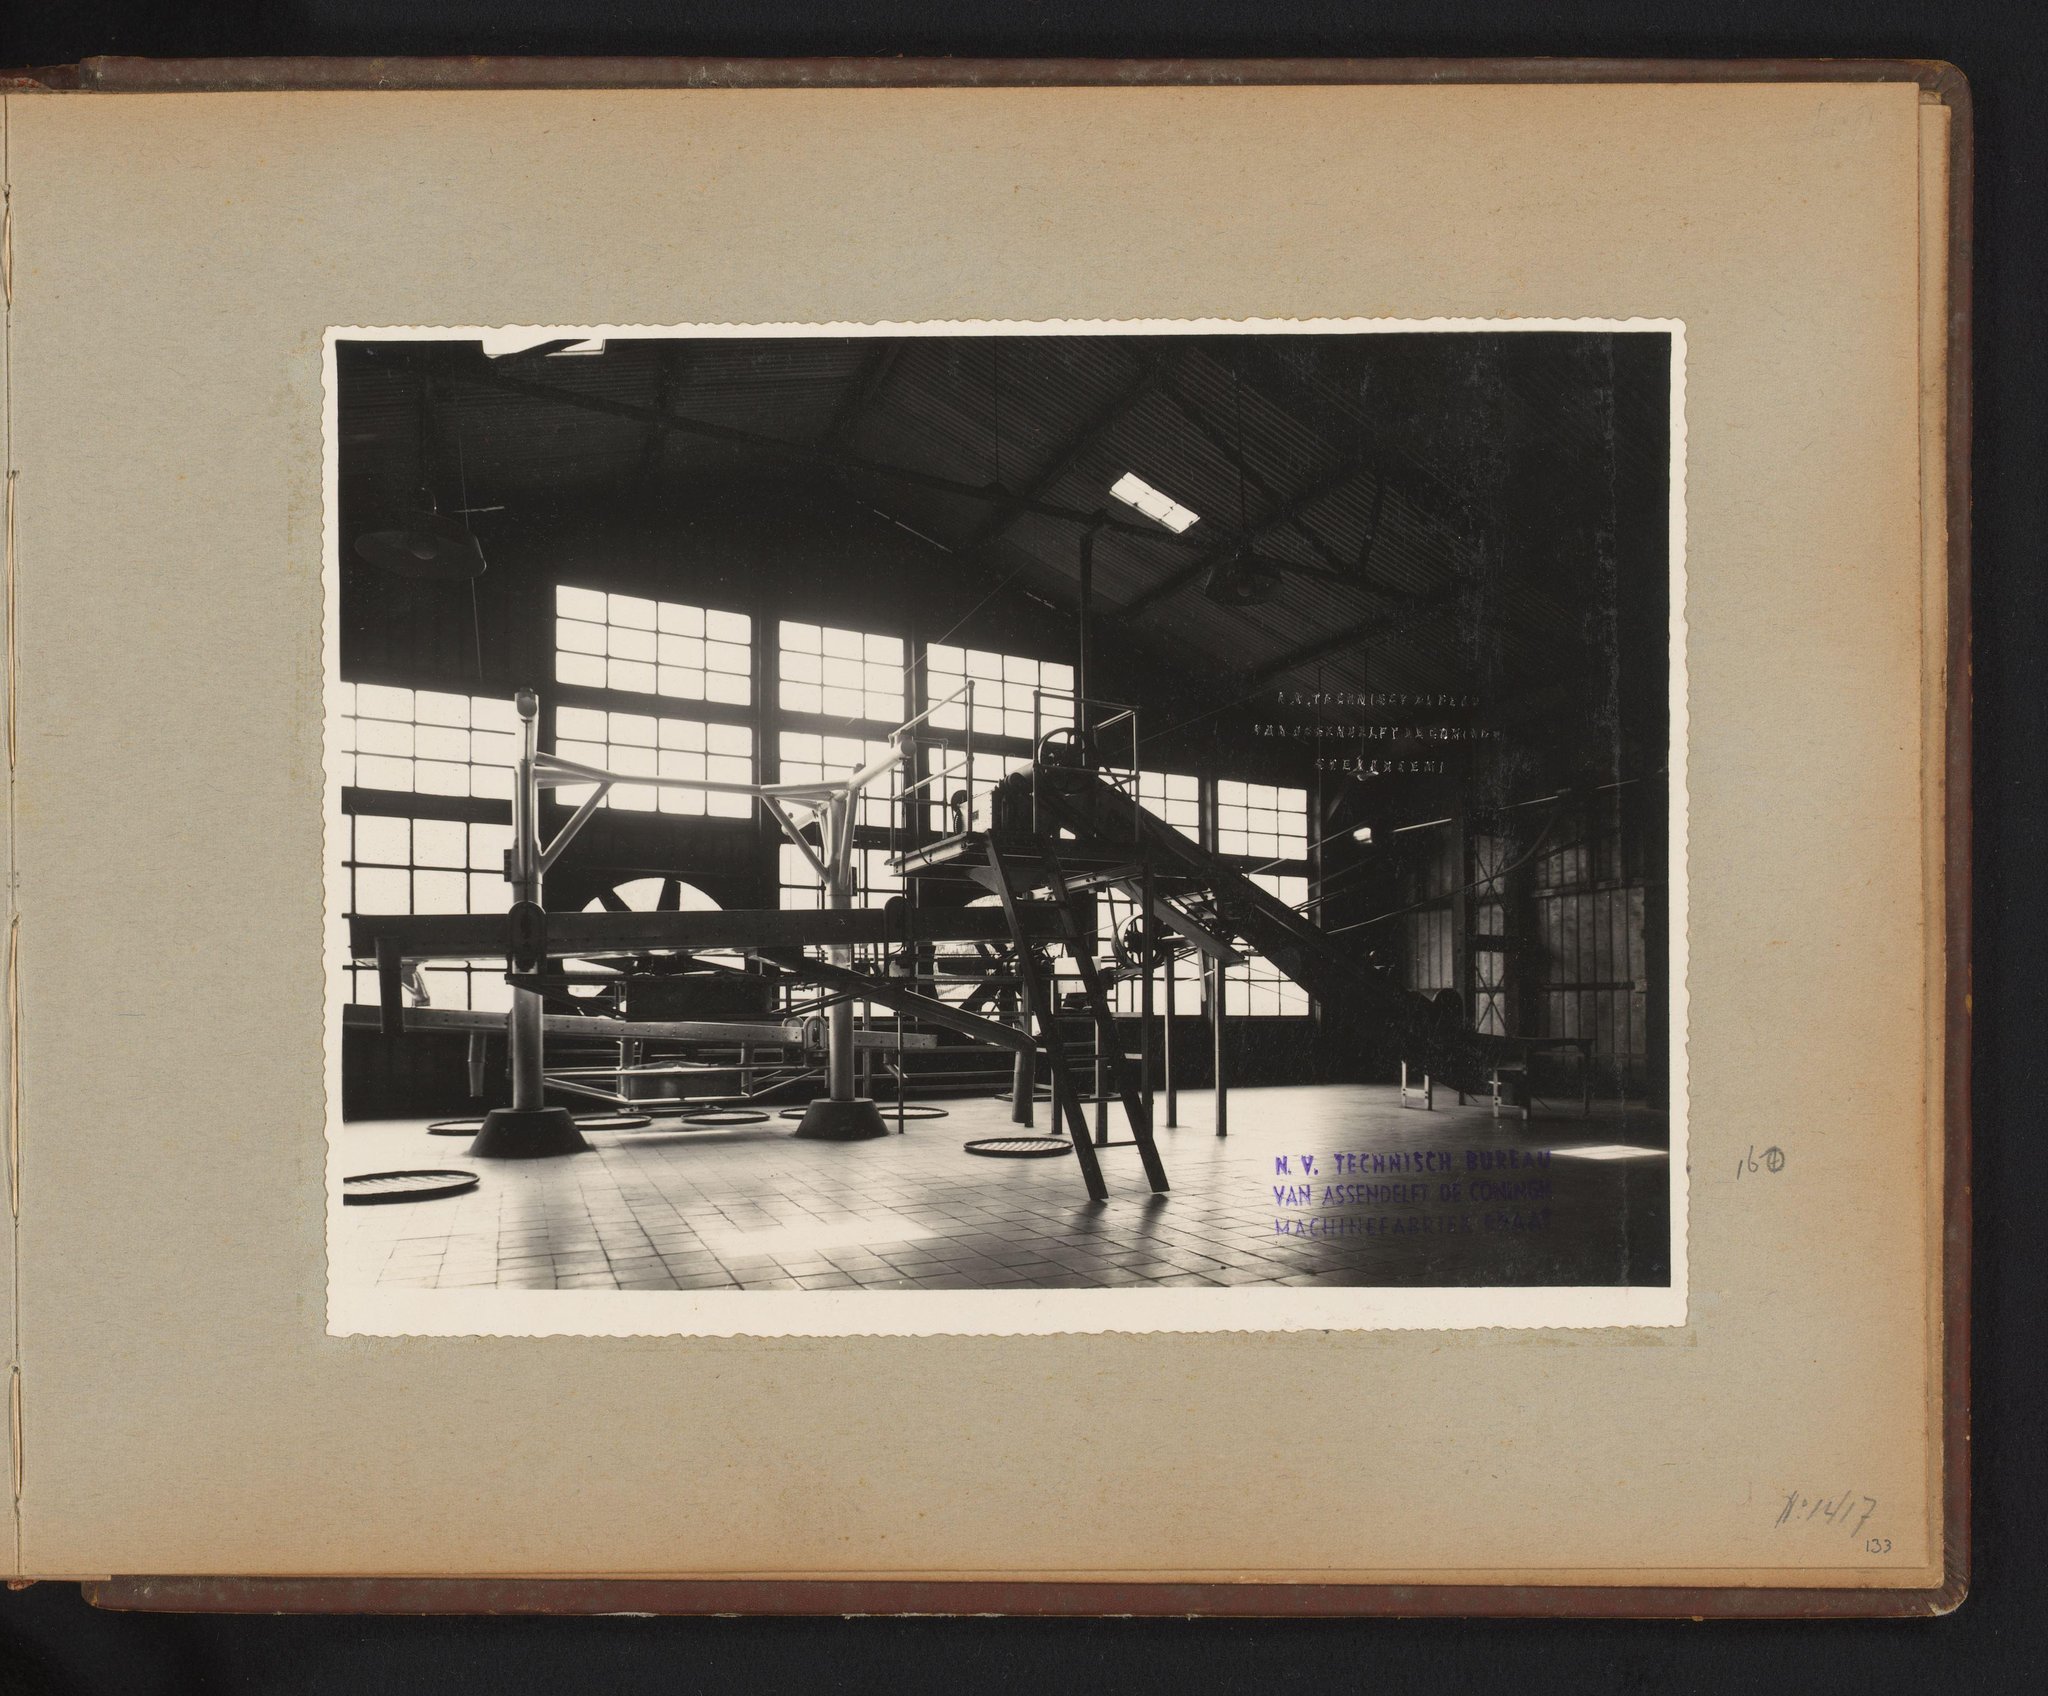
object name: album leaf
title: Installatie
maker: Anonymous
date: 1931-1937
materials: cardboard, photographic support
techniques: gelatin silver print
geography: soekaboemi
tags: factory-interior, machine shop, machines; parts of machines; tools and appliances, java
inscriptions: name: ‘N.V. Technisch Bureau Van Assendelft De Coningh Machinefabriek Braat’, name: ‘N.V. Technisch Bureau Van Assendelft De Coningh Soekaboemi’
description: Albumblad met een foto van een installatie met lopende banden. Ontworpen voor of door N.V. Technisch Bureau Van Assendelft De Coningh. Onderdeel van een fotoalbum met foto's van machines en constructies van de N.V. Machinefabriek Braat te Soerabaja, Soekaboemi en Tegal uit de periode 1931-1937.